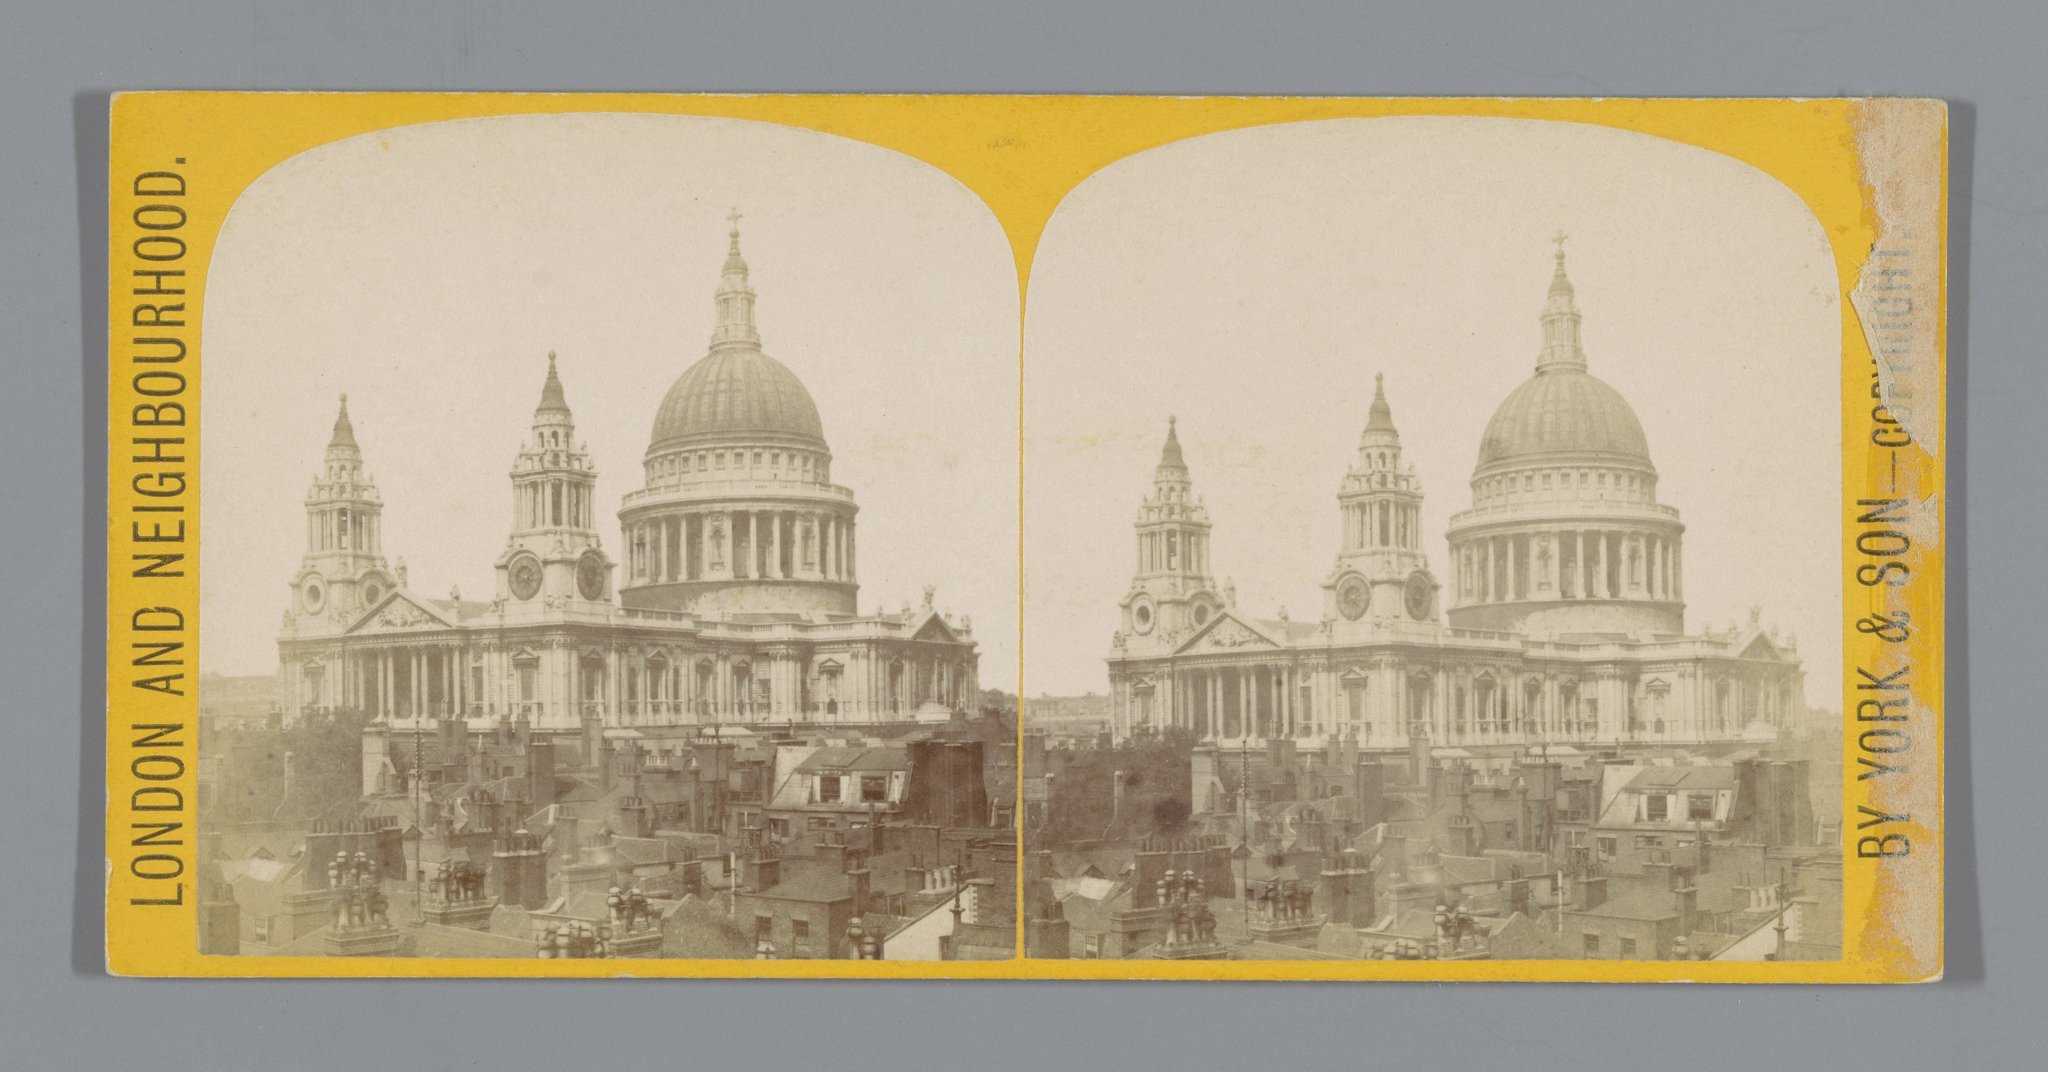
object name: stereograph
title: Gezicht op Saint Paul's Cathedral in Londen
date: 1860-1880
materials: cardboard, photographic support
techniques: albumen print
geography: london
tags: church (exterior)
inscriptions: number: ‘No. 17.’